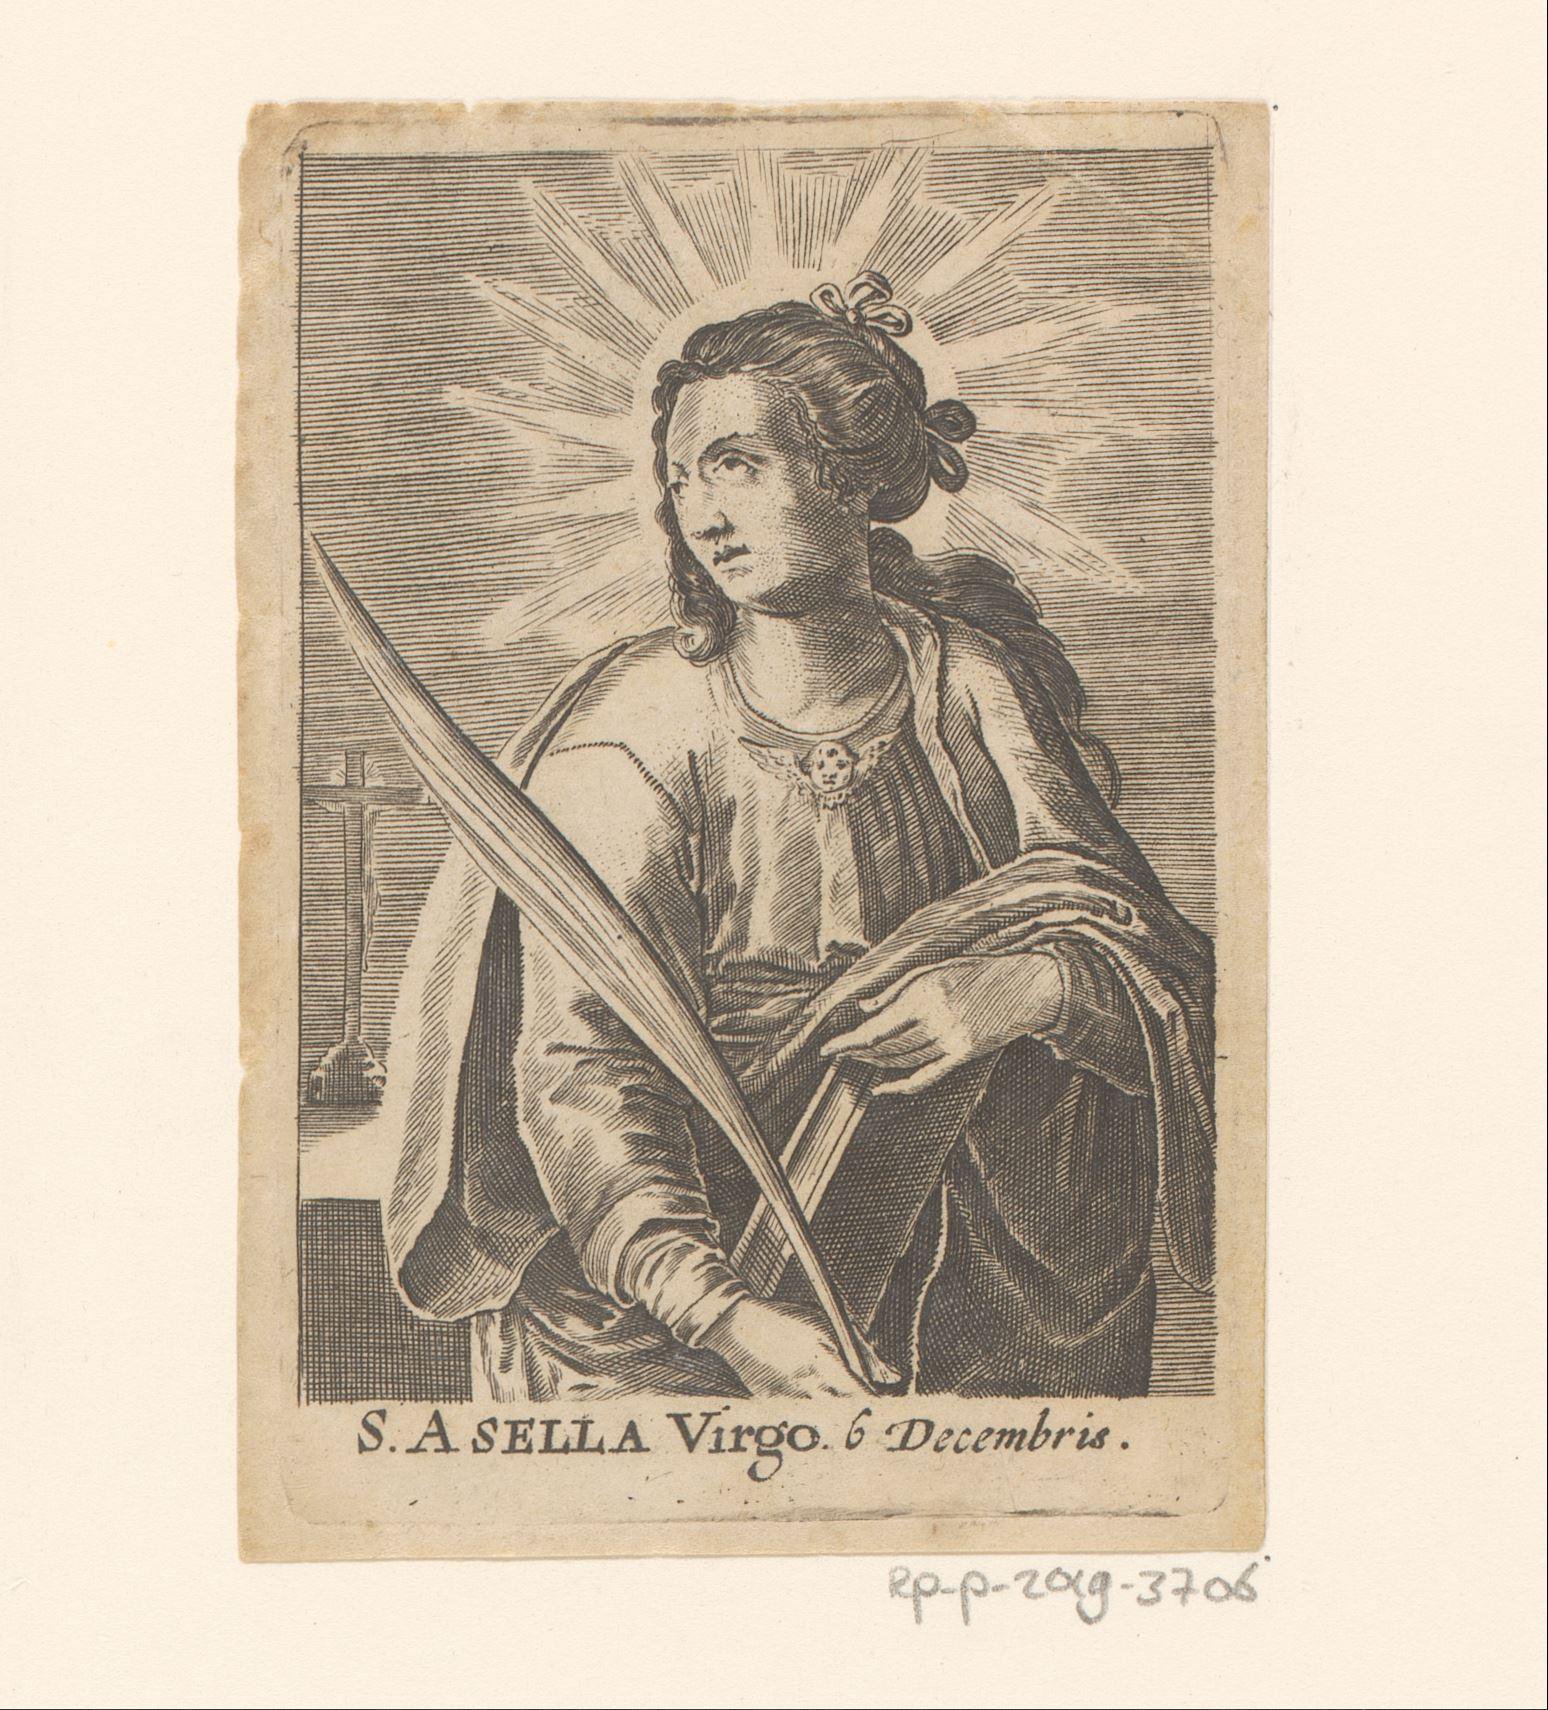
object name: print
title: S. Asella Virgo. 6 Decembris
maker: Anonymous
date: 1600-1699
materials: paper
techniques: engraving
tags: female saints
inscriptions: collector's mark: Lugt 2228